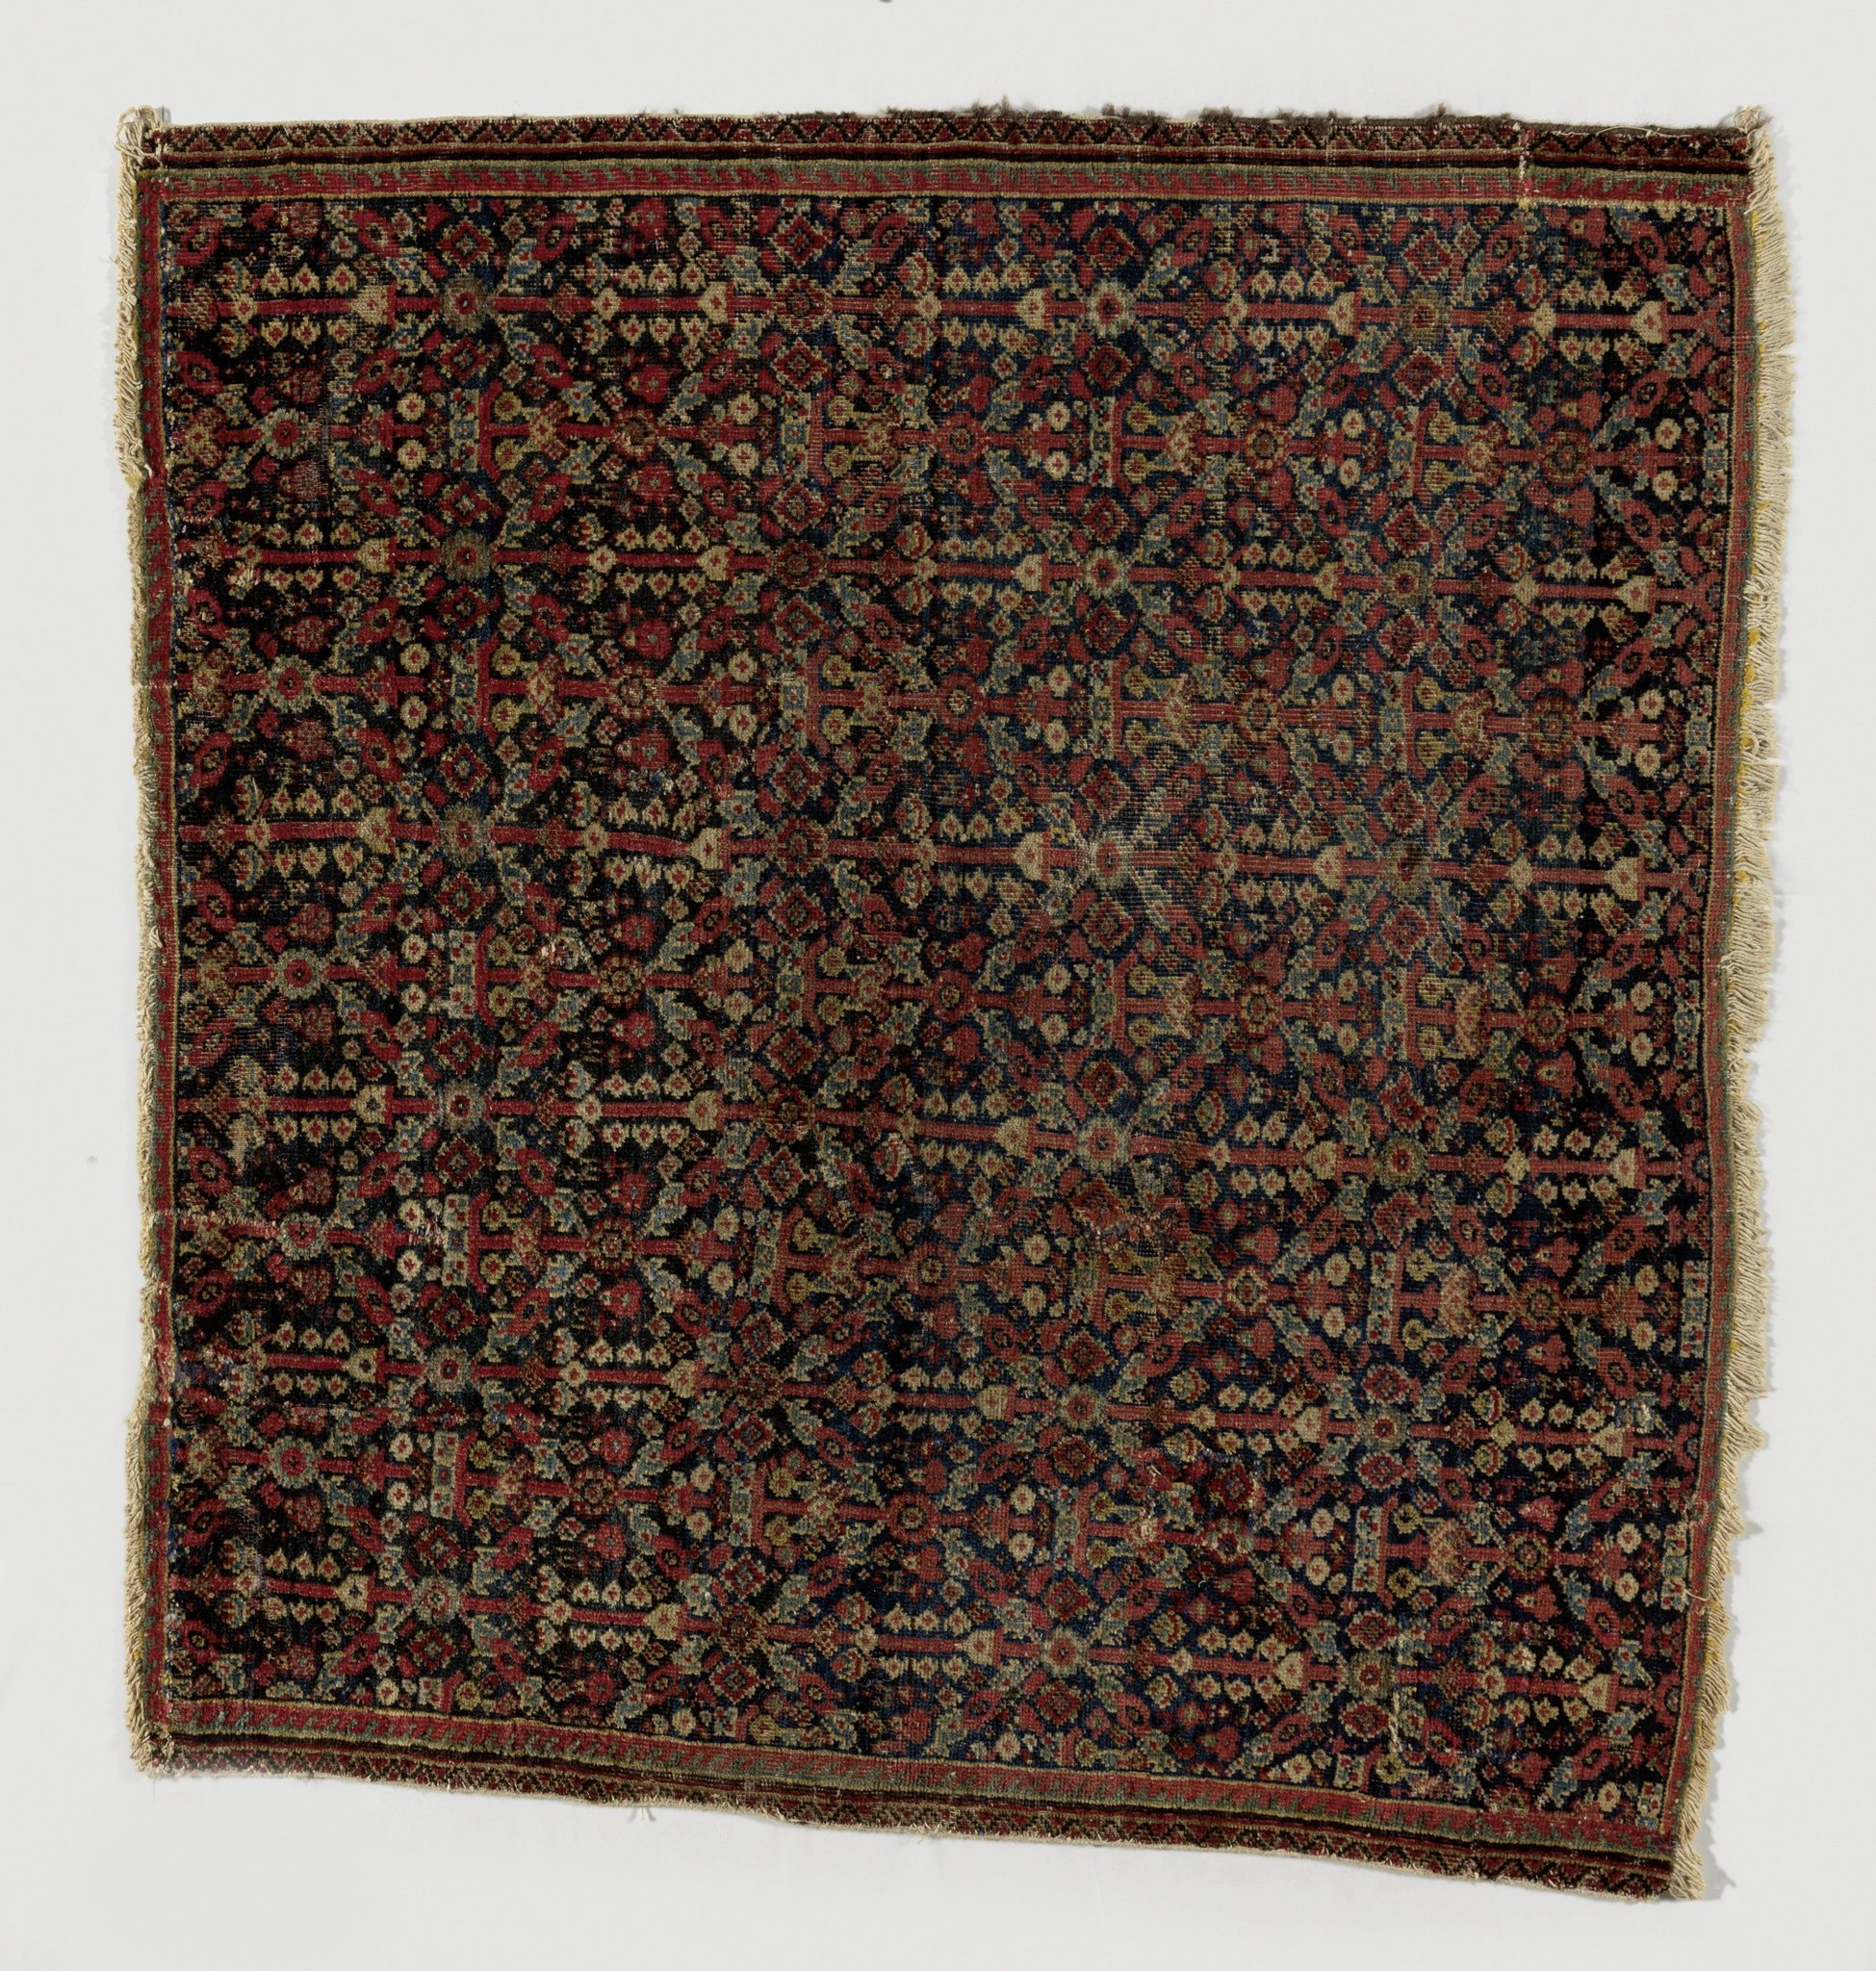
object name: fragment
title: Fragment van een Oosters tapijt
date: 1850-1900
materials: cotton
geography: ferahan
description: Fragment van een Oosters tapijt, bloemenkleed. In het middenveld een rasterpatroon gevuld met gestileerde bloemen en bloemboeketten en kleine dierfiguren langs de verticale assen tegen een donkerblauwe achtergrond. Hoofdrand ontbreekt.